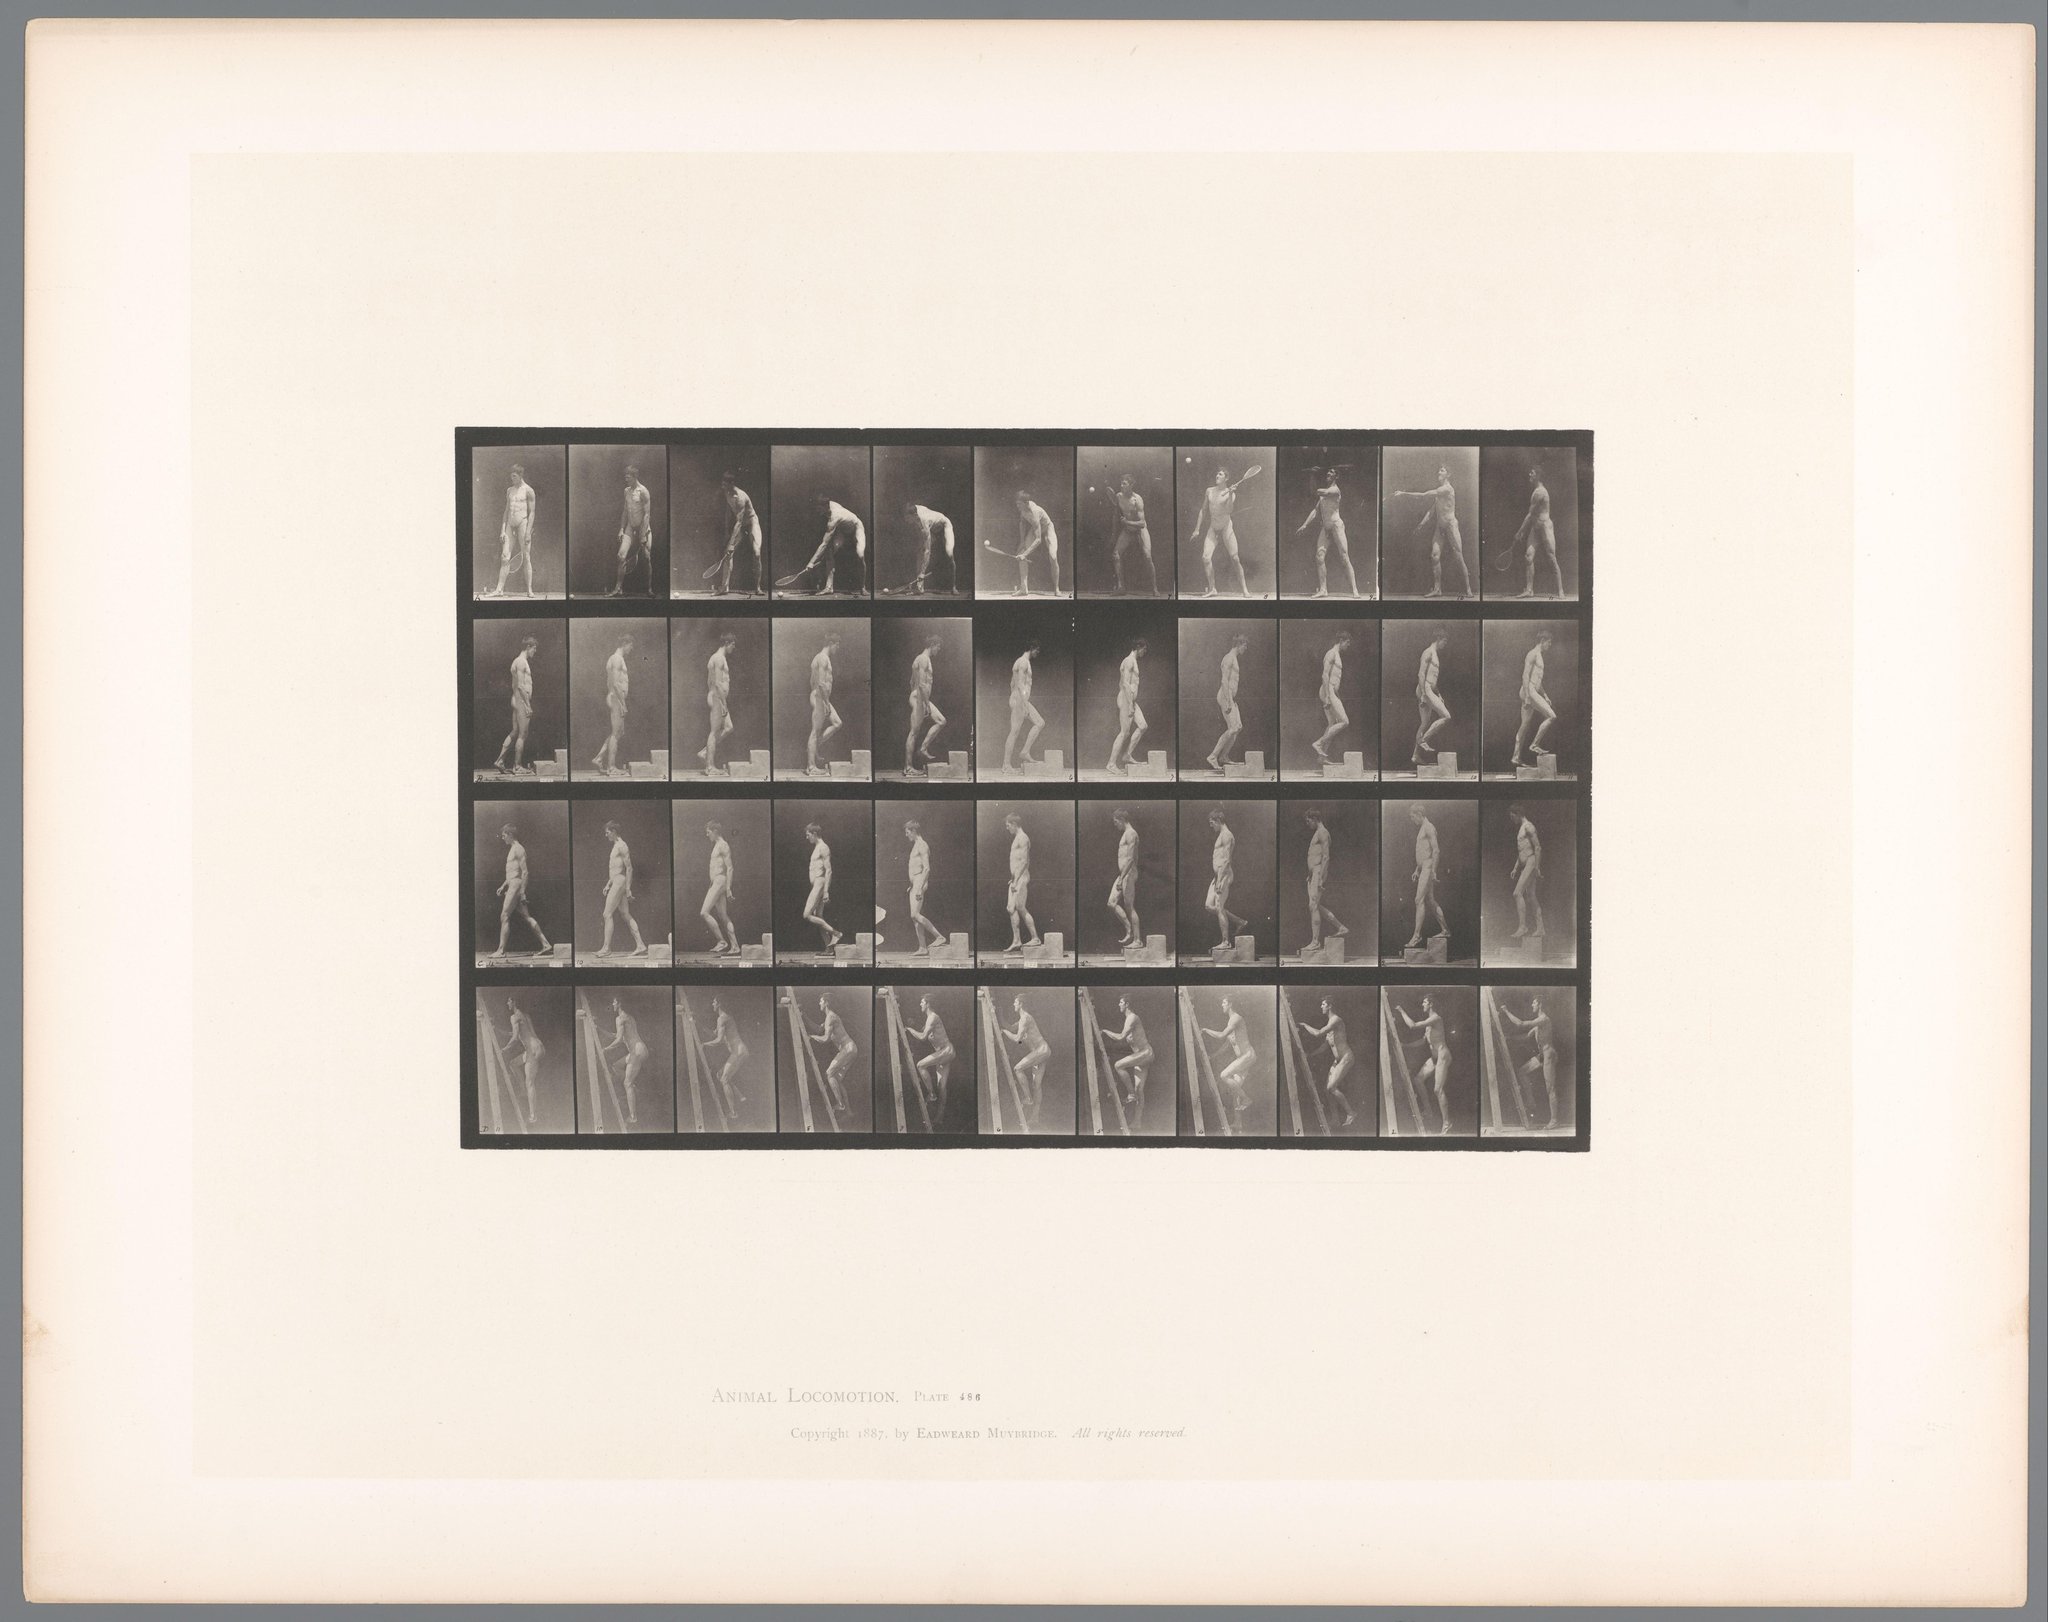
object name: fotosequentie, pocketcinema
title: Man Playing Lawn Tennis, Ascending and Descending a Step, and Ascending a Ladder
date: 1887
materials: paper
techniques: photograph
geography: united states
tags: tennis, lawn-tennis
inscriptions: number: ‘PLATE 486’, copyright notice: ‘Copyright 1887, by EADWARD MUYBRIDGE. All rights reserved.’, number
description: While Muybridge initially limited his studies of motion to a horse galloping, he later branched out and experimented with other animals and people. This resulted in the publication of Animal Locomotion in 1887, which included 781 plates of moving horses, elephants, lions, storks, other animals, and people. He had them walk, run, and fly a fixed track, and set up banks of cameras to record their motion.